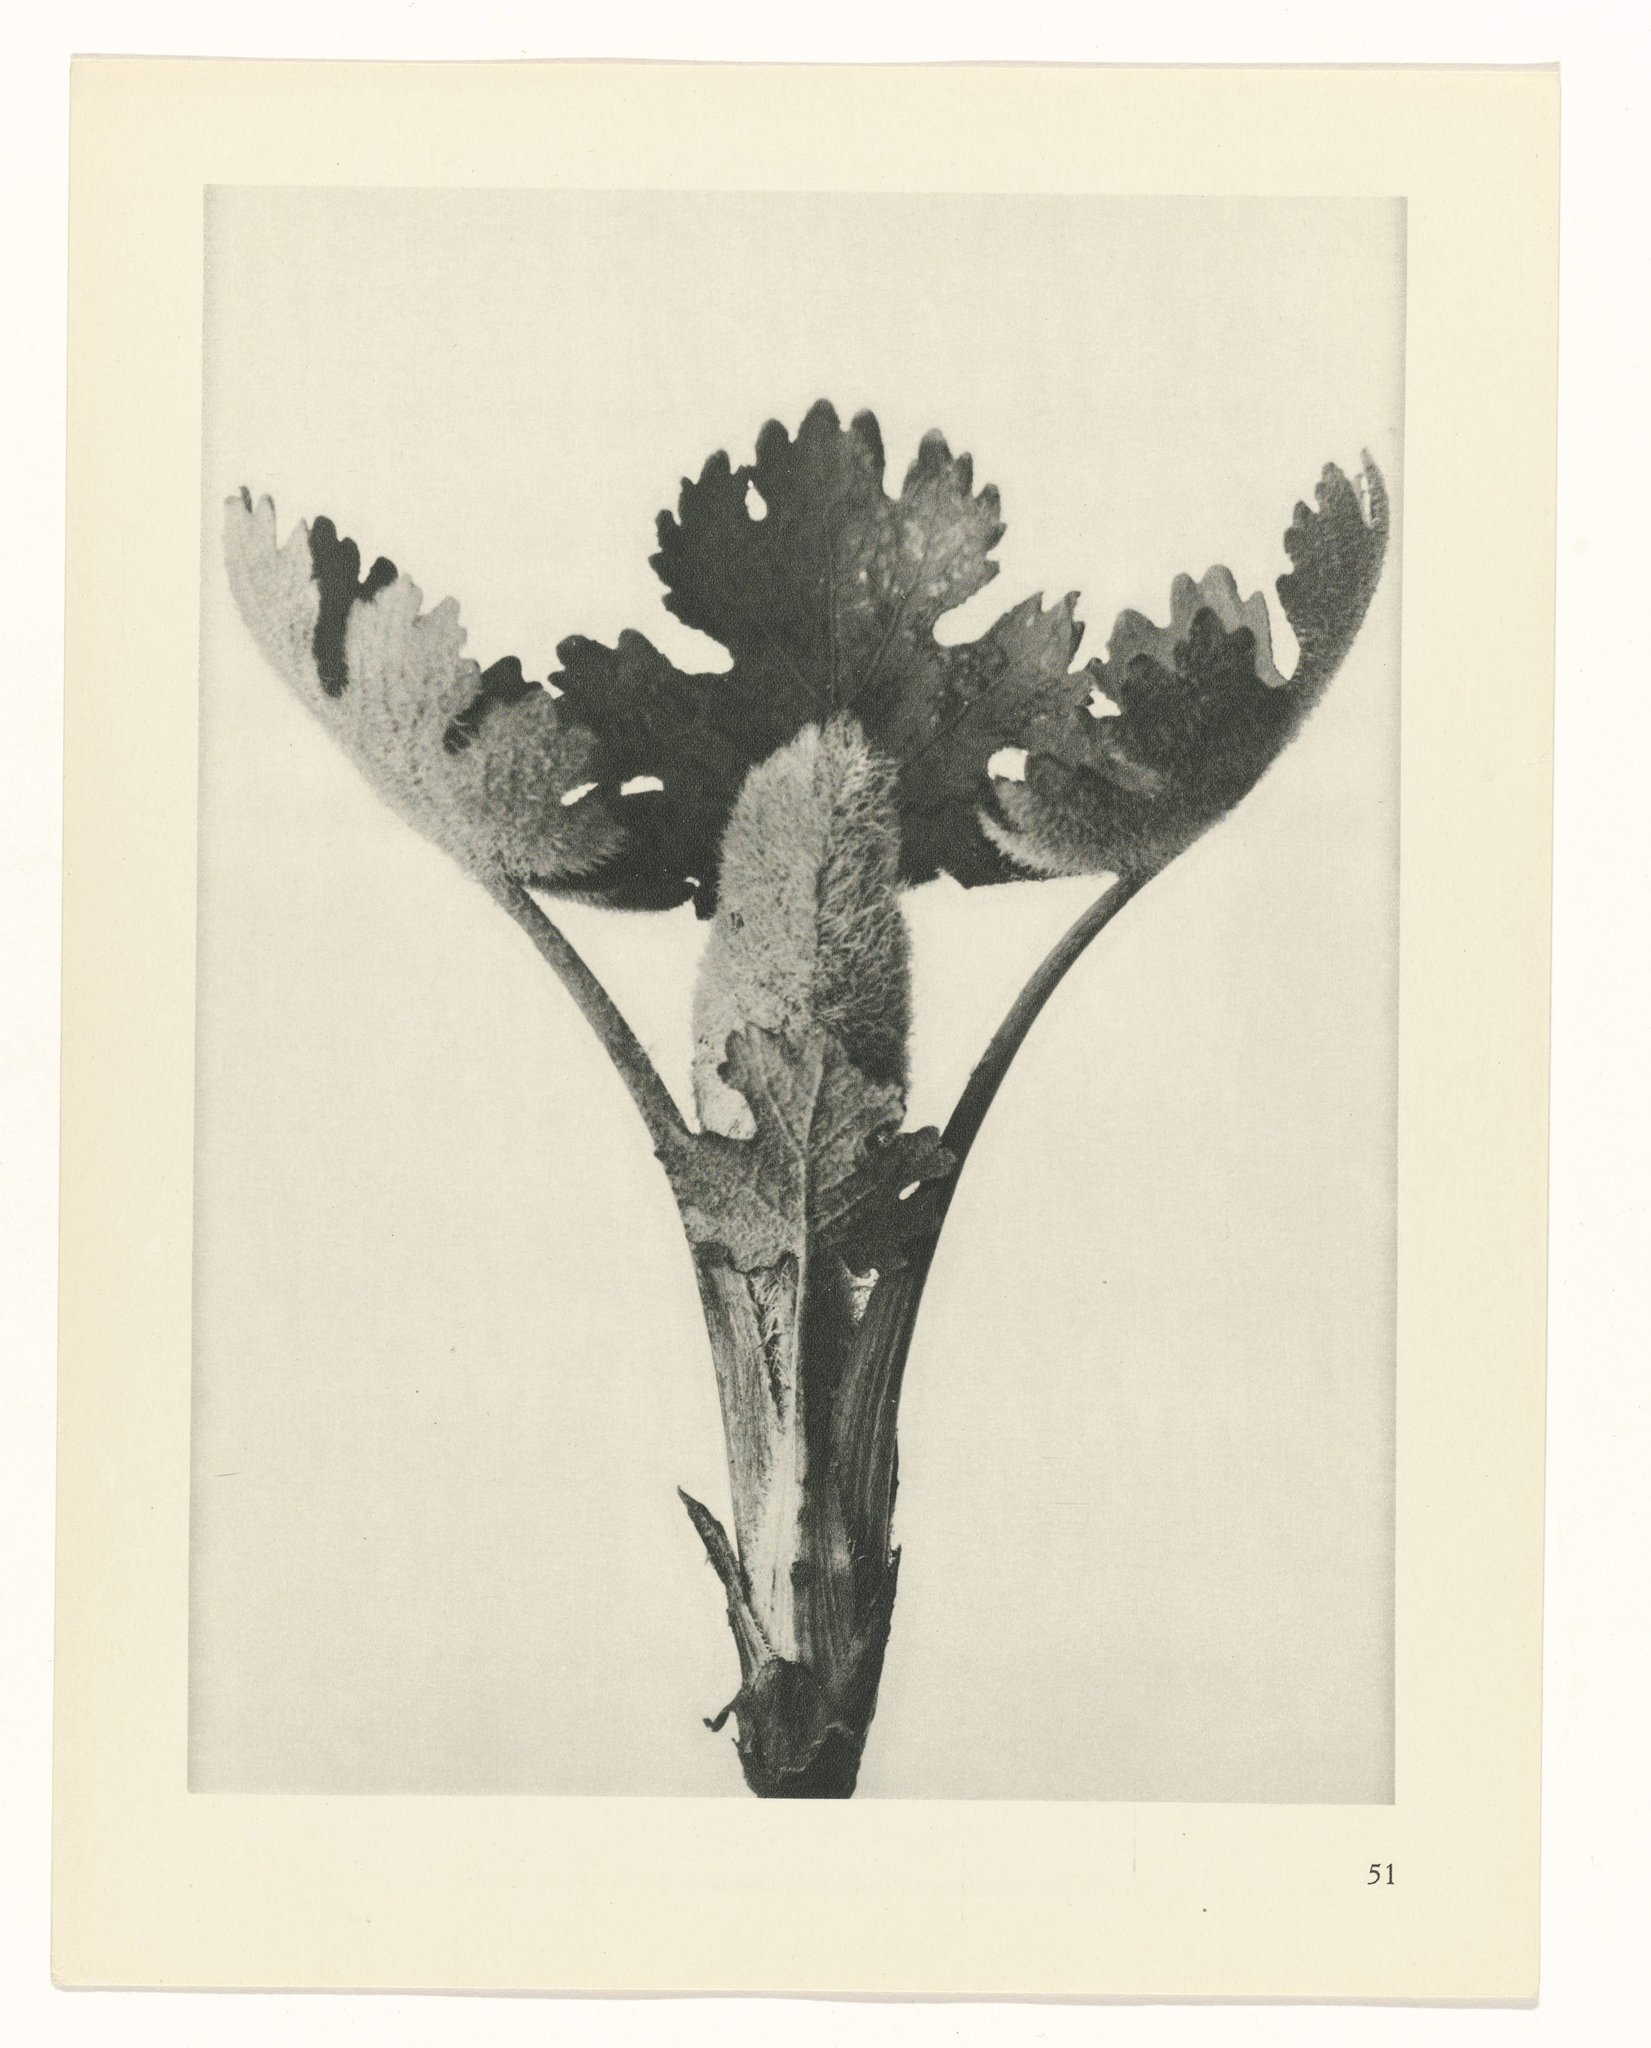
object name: photograph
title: Urformen der Kunst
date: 1928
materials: ink, paper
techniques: rotogravure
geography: berlin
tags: plants (in general)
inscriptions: number: ‘51’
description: facher Vergrößerung. Afkomstig uit losbladige uitgave.